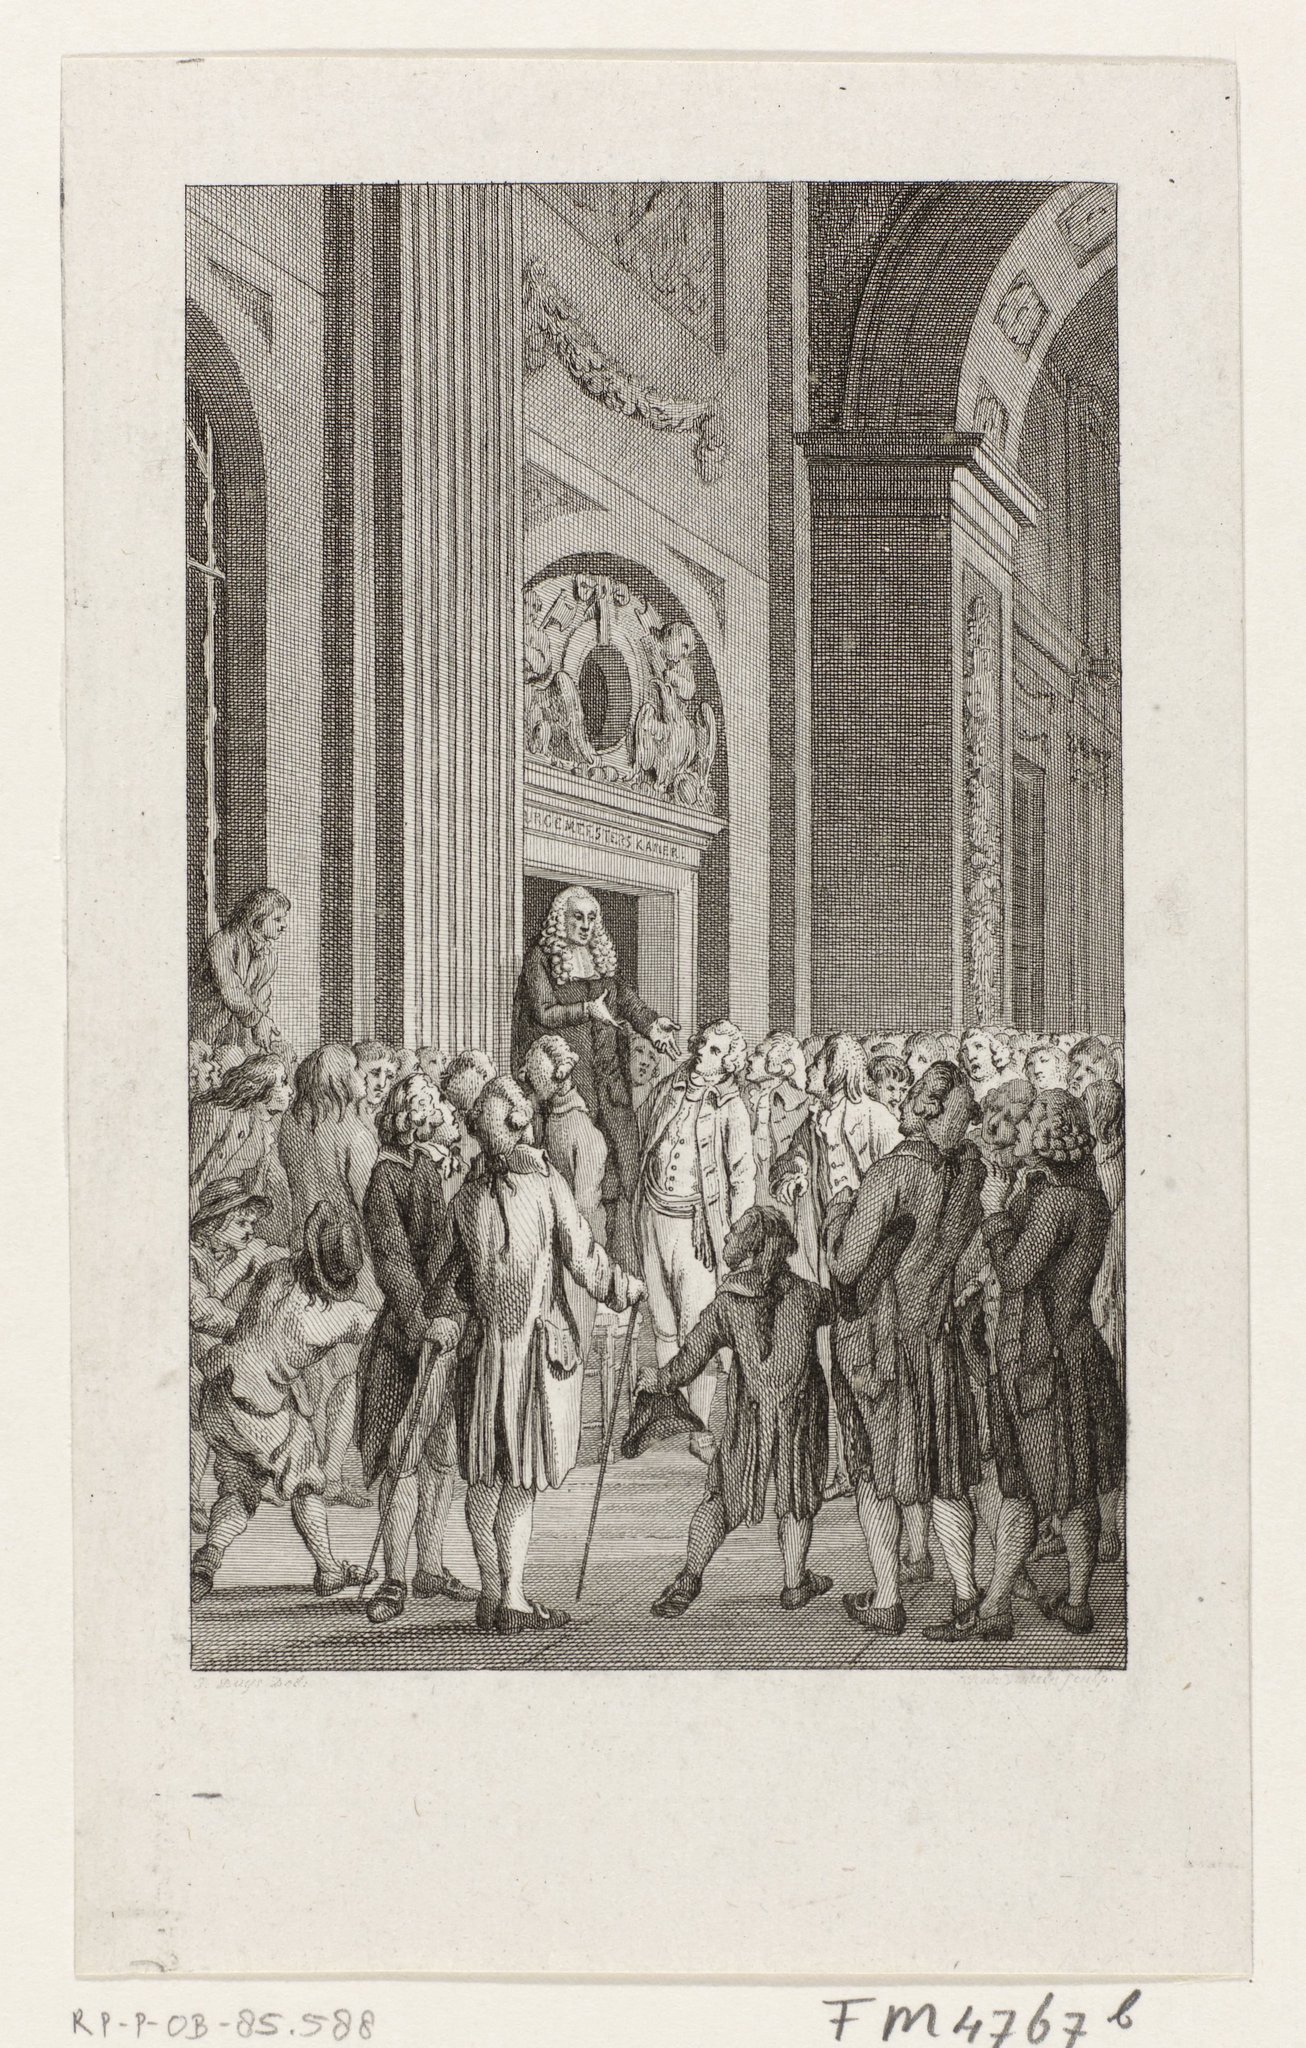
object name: history print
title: Burgemeester Hendrik Hooft Danielsz onderhandelt met de burgerij, 1787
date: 1796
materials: paper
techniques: engraving, etching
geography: northern netherlands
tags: amsterdam, mayor, hendrik danielsz. hooft, rijngraaf van salm frederik iii, crowd, mob, mayor, burgomaster, person addressing a group, orator, patriots (1780-1795)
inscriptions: collector's mark: Lugt 2228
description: De Amsterdamse burgemeester Hendrik Danielsz. Hooft onderhandelt met de burgerij over het afdanken van de Rijngraaf van Salm, 26 februari 1787. Hooft spreekt staande voor de ingang van de burgemeesterskamer in het Stadhuis de samengestroomde burgers toe.